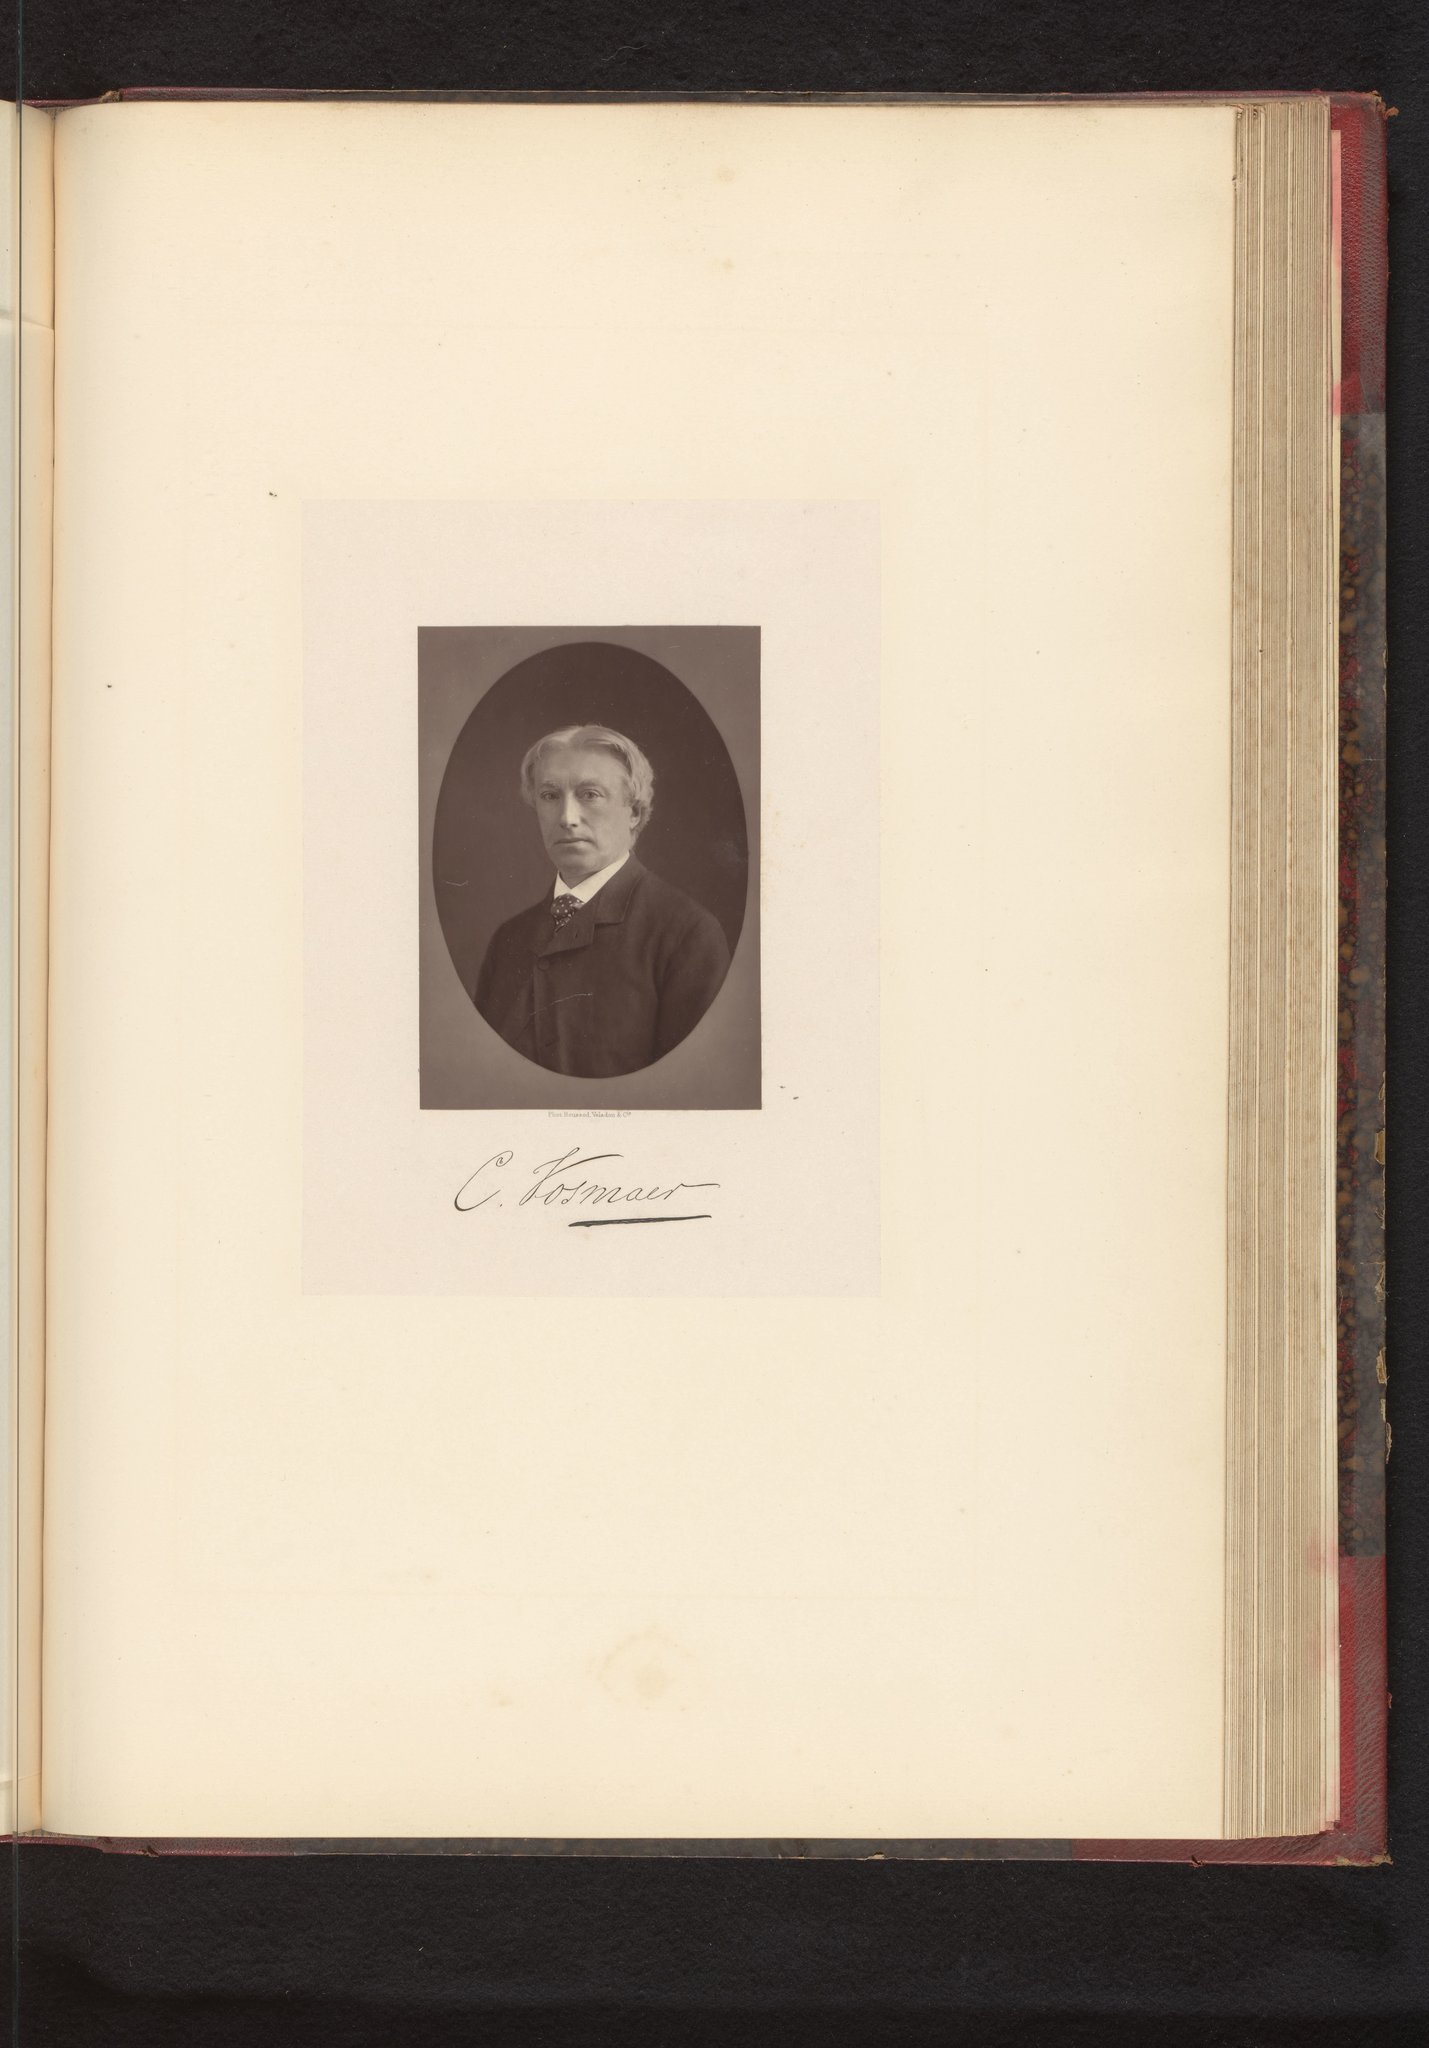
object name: photomechanical print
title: Portret van Carel Vosmaer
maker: Anonymous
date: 1878-1887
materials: paper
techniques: woodburytype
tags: the hague, print maker, draughtsman, carel vosmaer, historical persons, writer, poet, author